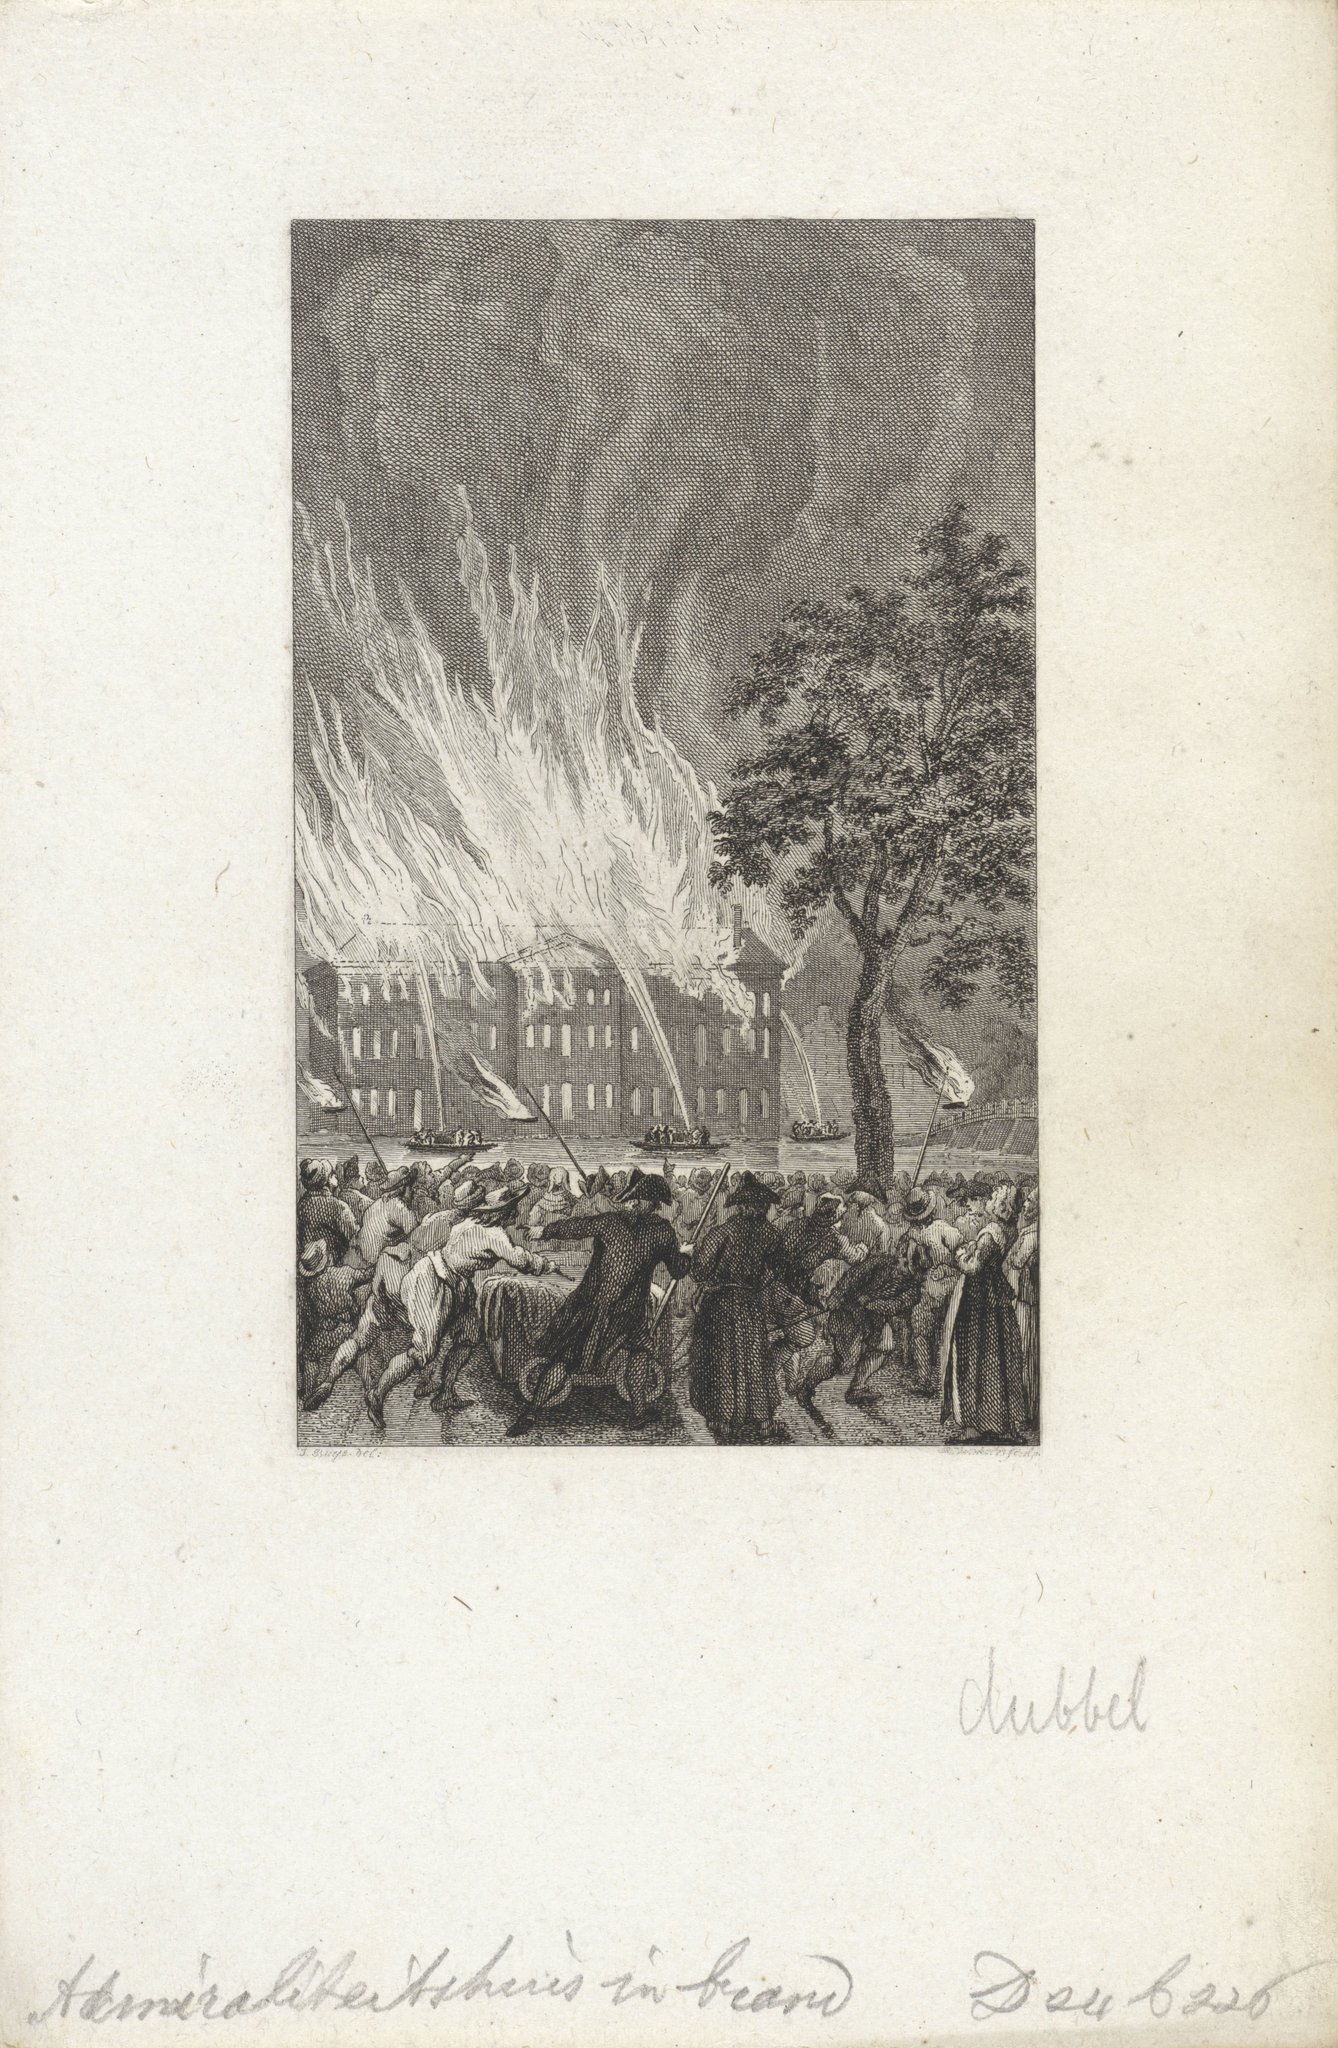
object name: print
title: Brand in 's Lands Zeemagazijn, 1791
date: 1800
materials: paper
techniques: engraving, etching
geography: amsterdam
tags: on fire, ablaze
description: Gebruikt als illustratie in: P.A. Loosjes. Vaderlandsche historie, vervattende de geschiedenissen, der Vereenigde Nederlanden (...). Ten onmiddelyken vervolge van Wagenaar's Vaderlandsche historie. Amsterdam: Johannes Allart, dl. 24 (1800).